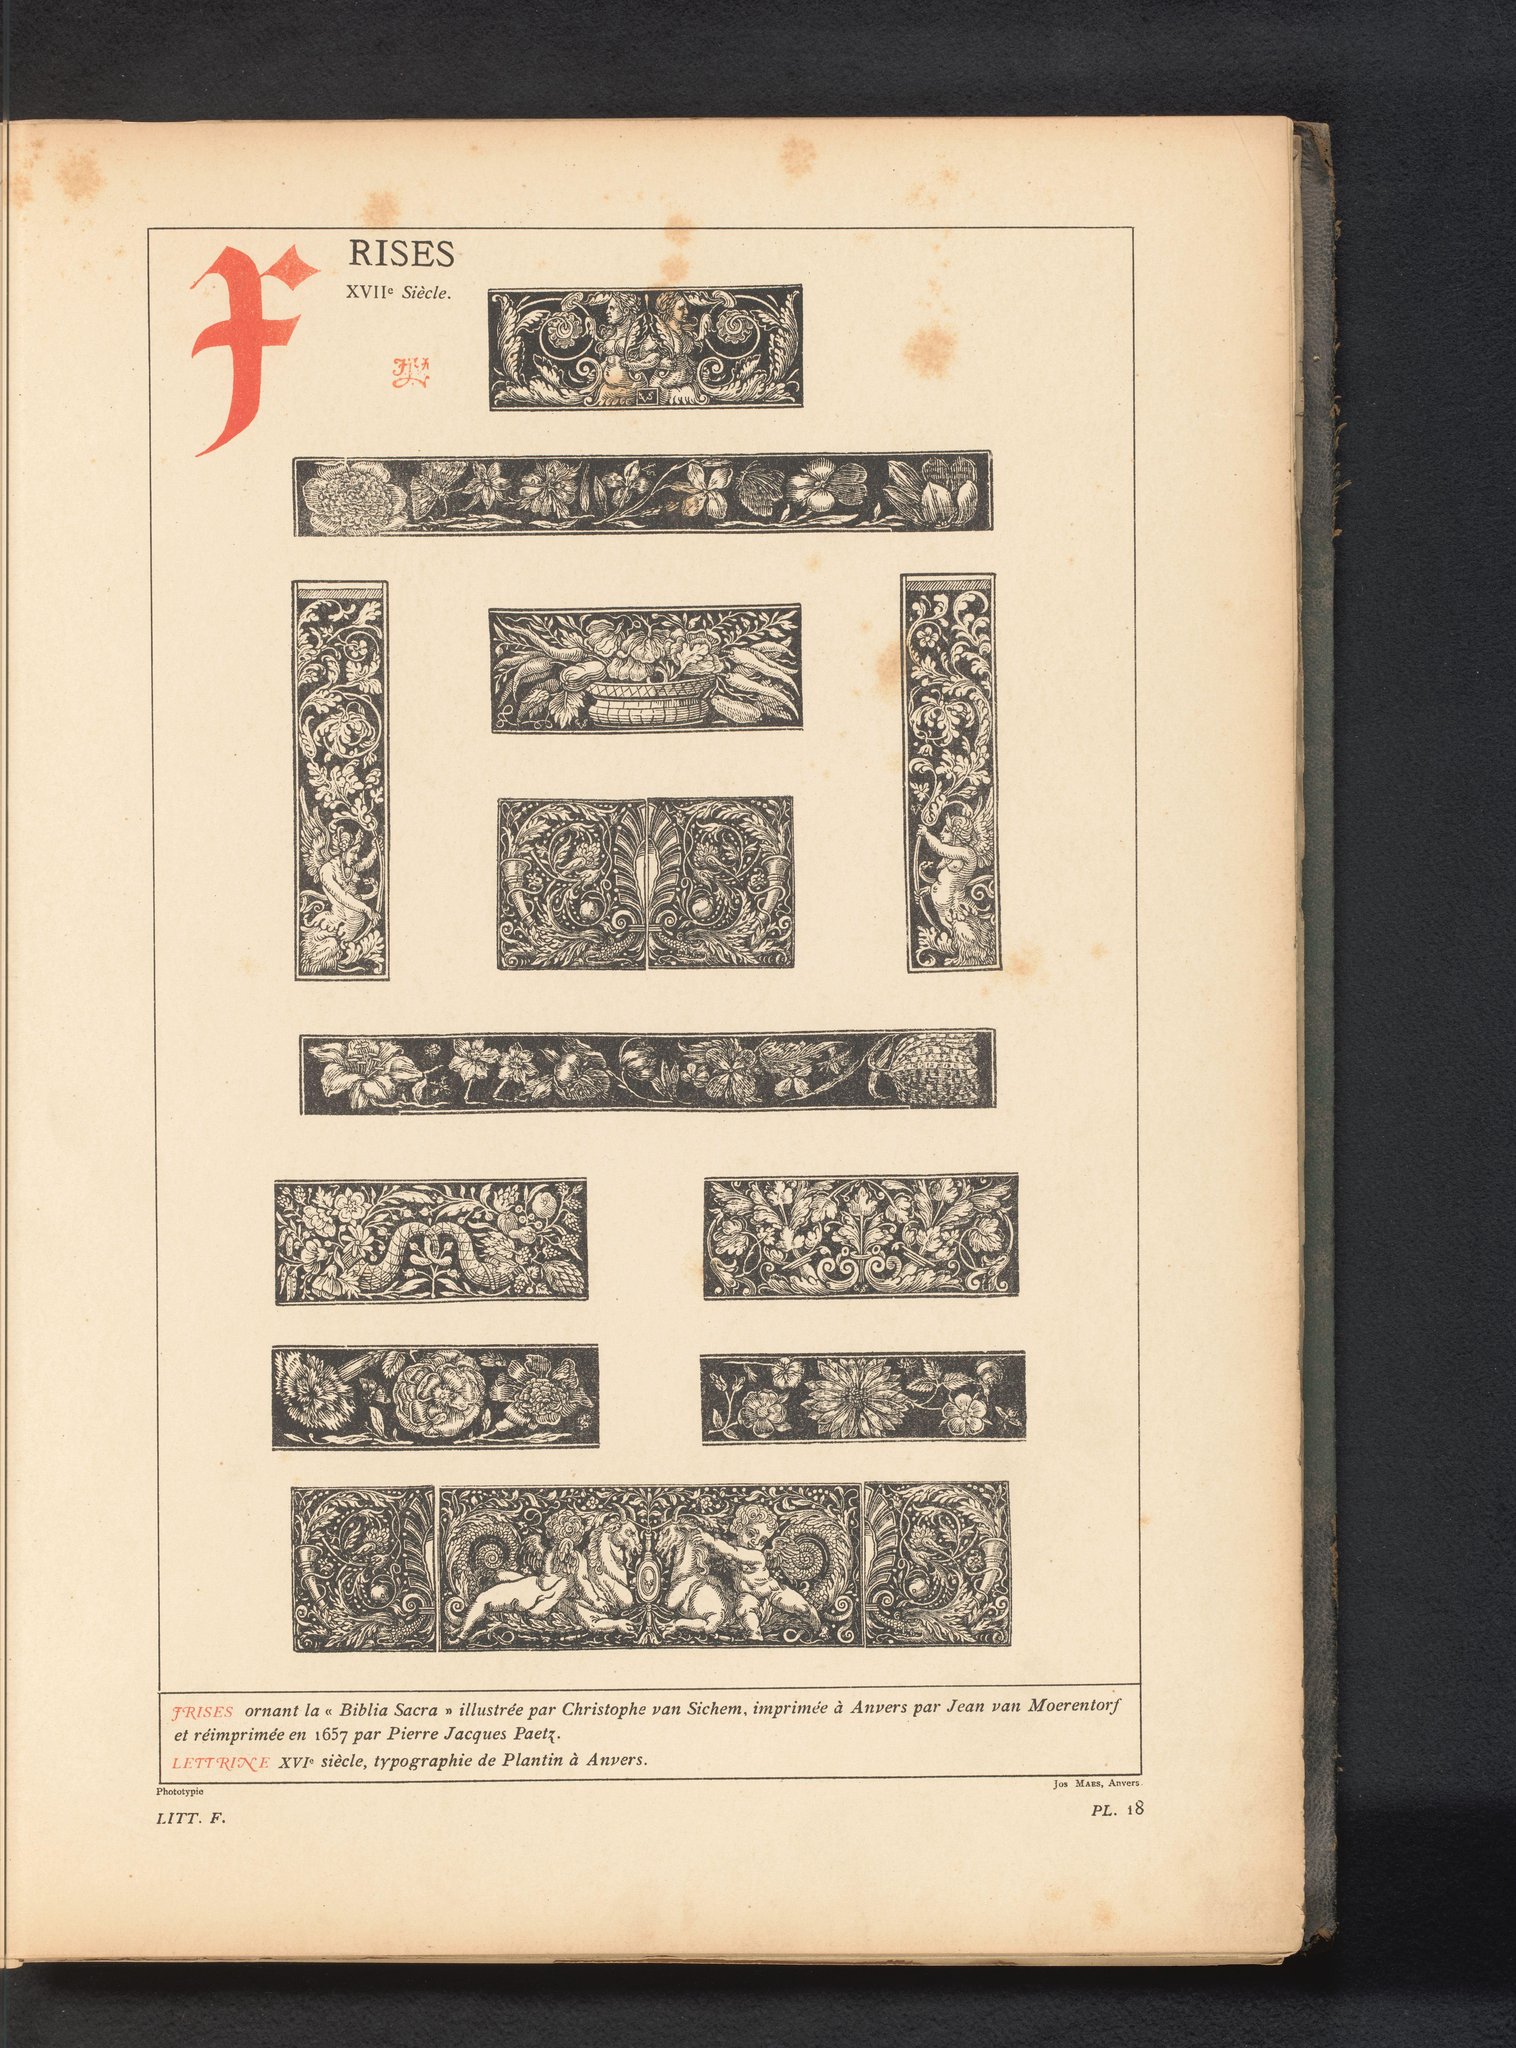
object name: photomechanical print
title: Frises, XVIIe Siècle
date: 1875-1880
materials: paper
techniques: photolithography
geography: antwerp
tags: ornament ~ grotesque, cupids: 'amores', 'amoretti', 'putti', ornament derived from plant forms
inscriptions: inscription: ‘FRISES ornant la (...)’, inscription: ‘LITT. F. - PL. 18’, monogram: ‘JJvY’